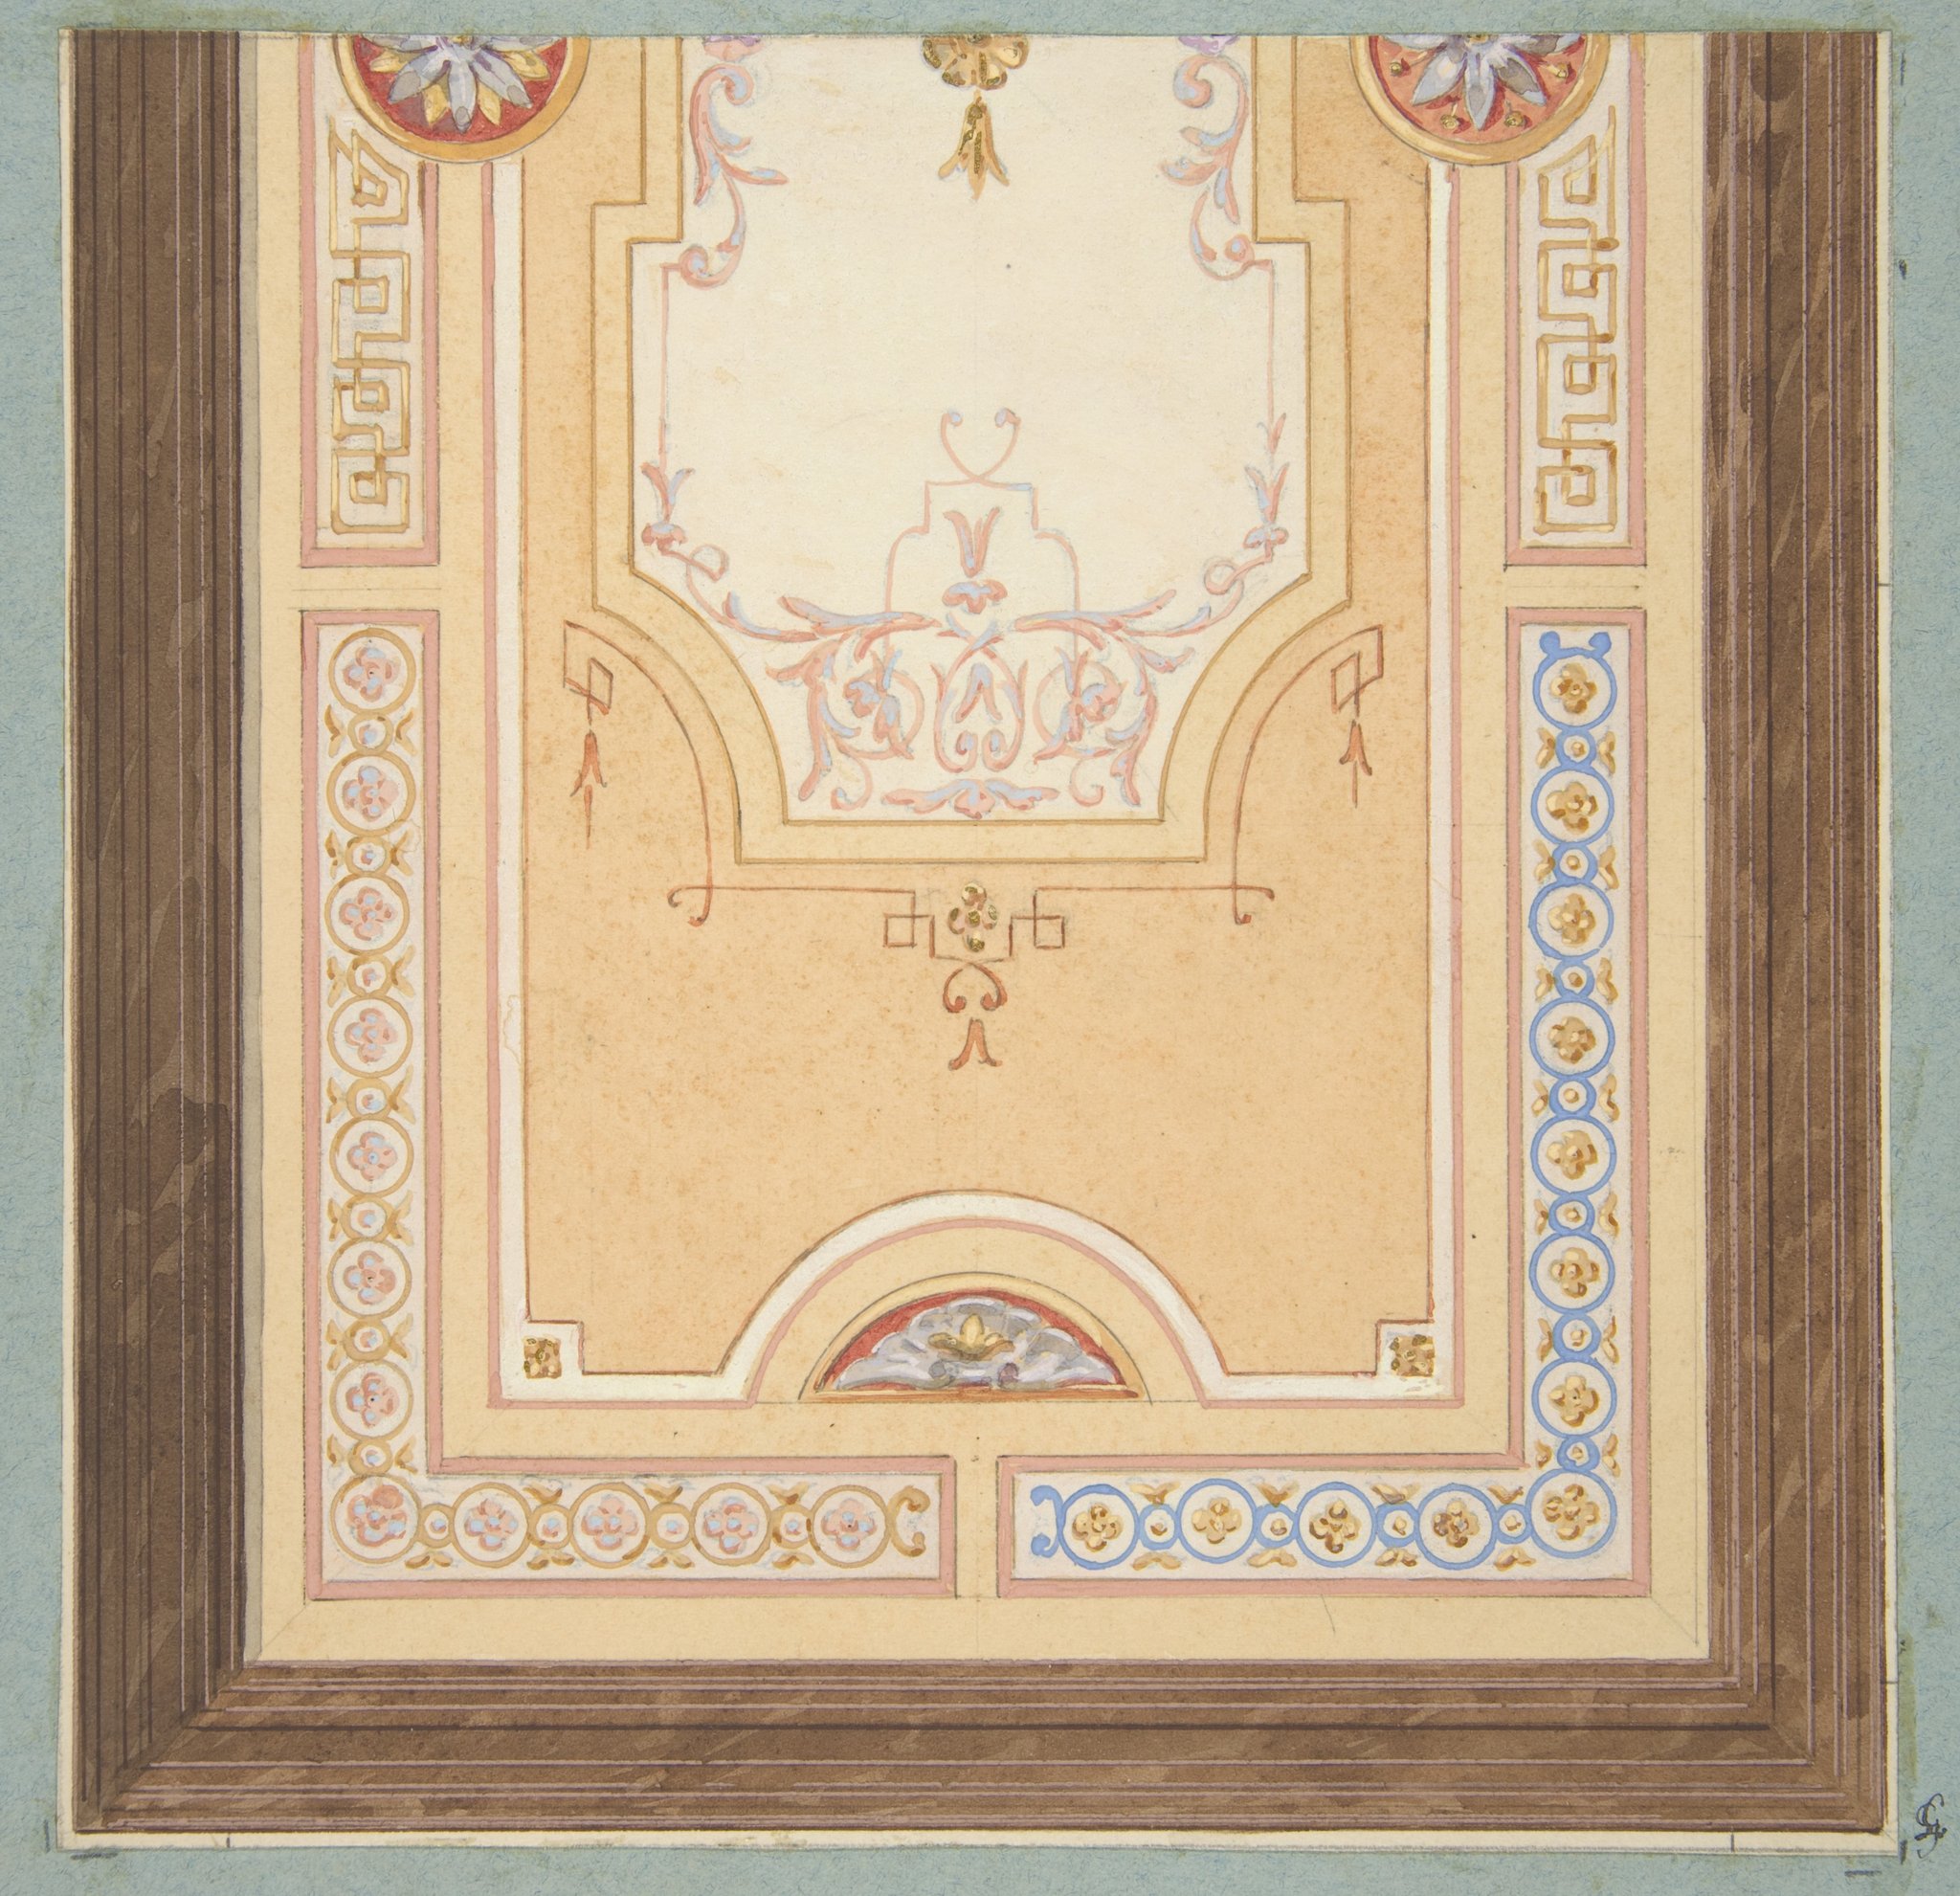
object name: drawing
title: Design for the painted decoration of a ceiling in with strapwork and rinceaux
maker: jules-edmond-charles lachaise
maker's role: artist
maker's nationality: french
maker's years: 1897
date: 1830-1897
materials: gouache, ink, watercolor, paper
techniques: heightening, pen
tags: ceilings